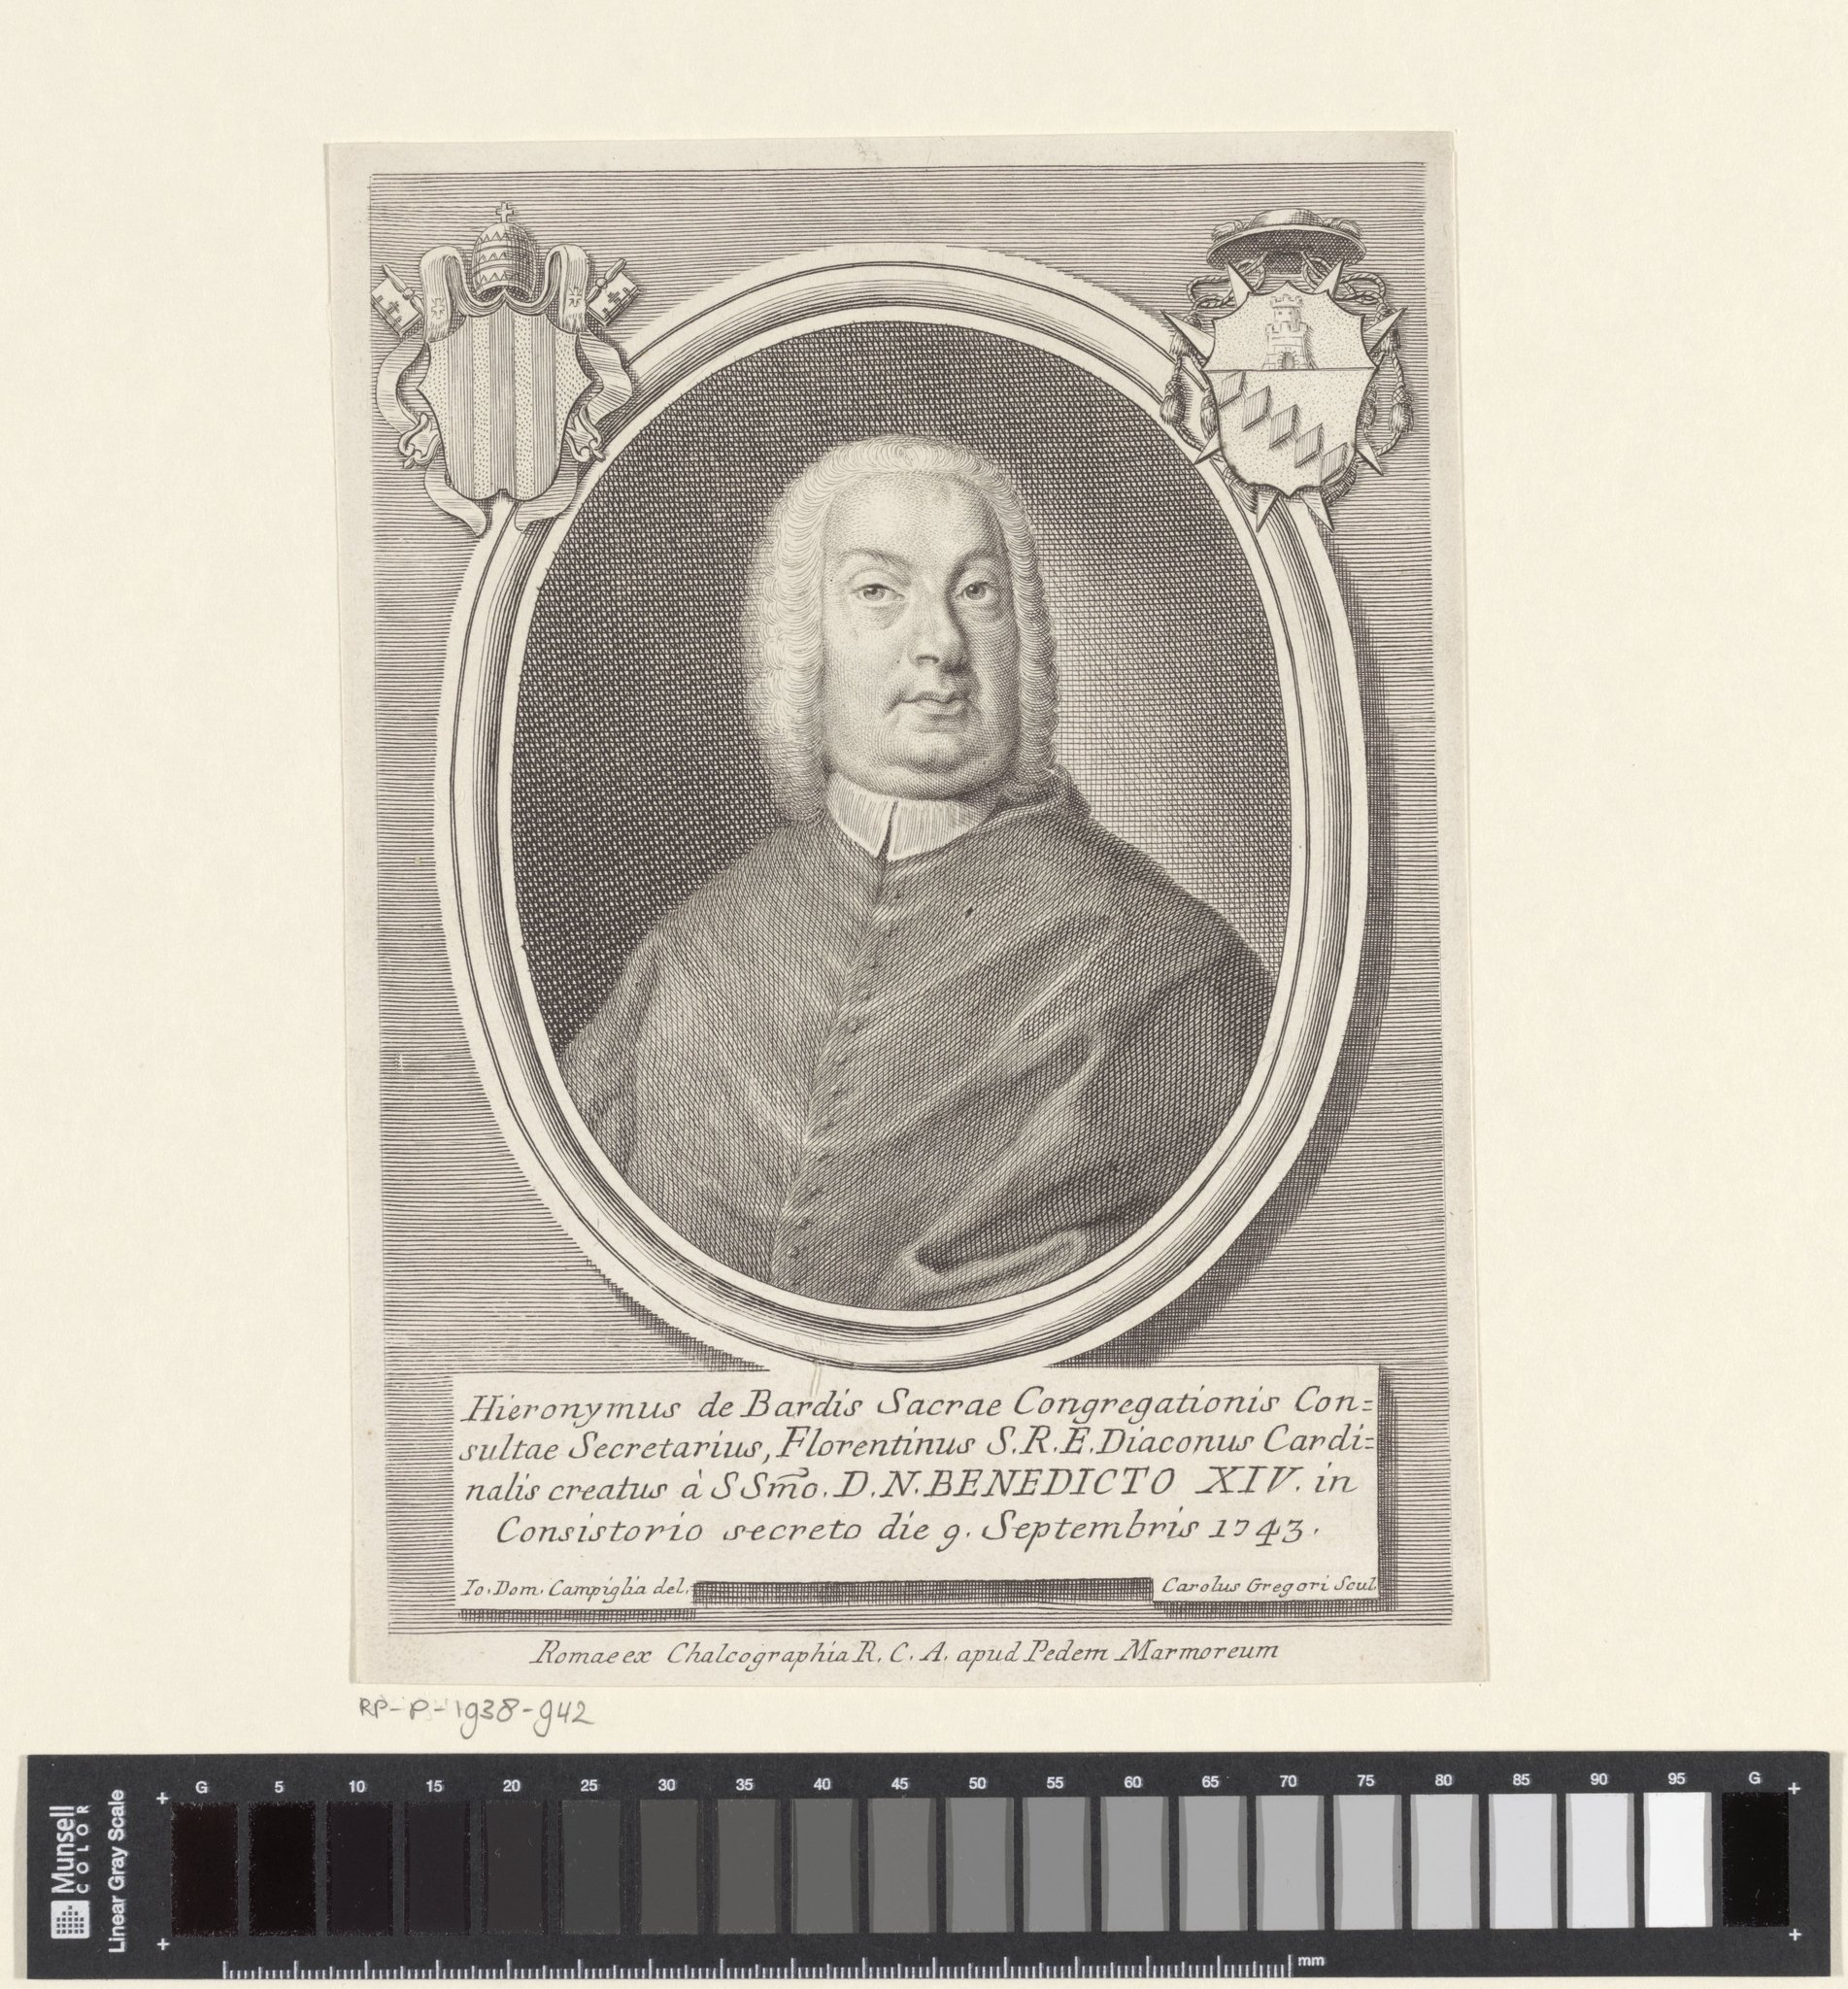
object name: print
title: Effigies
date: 1729-1759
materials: paper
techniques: engraving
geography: italy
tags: cardinal, historical persons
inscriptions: collector's mark: Lugt 2228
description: Prent uit een reeks van onbekende omvang met portretten van kardinalen. De prenten werden vanaf 1657 vervaardigd in opdracht van uitgever Giovanni Giacomo de’ Rossi, waarna de productie werd voortgezet onder leiding van zijn opvolgers Domenico de’ Rossi en Lorenzo Filippo de’ Rossi, en tenslotte onder leiding van de Calcographia R.C.A.